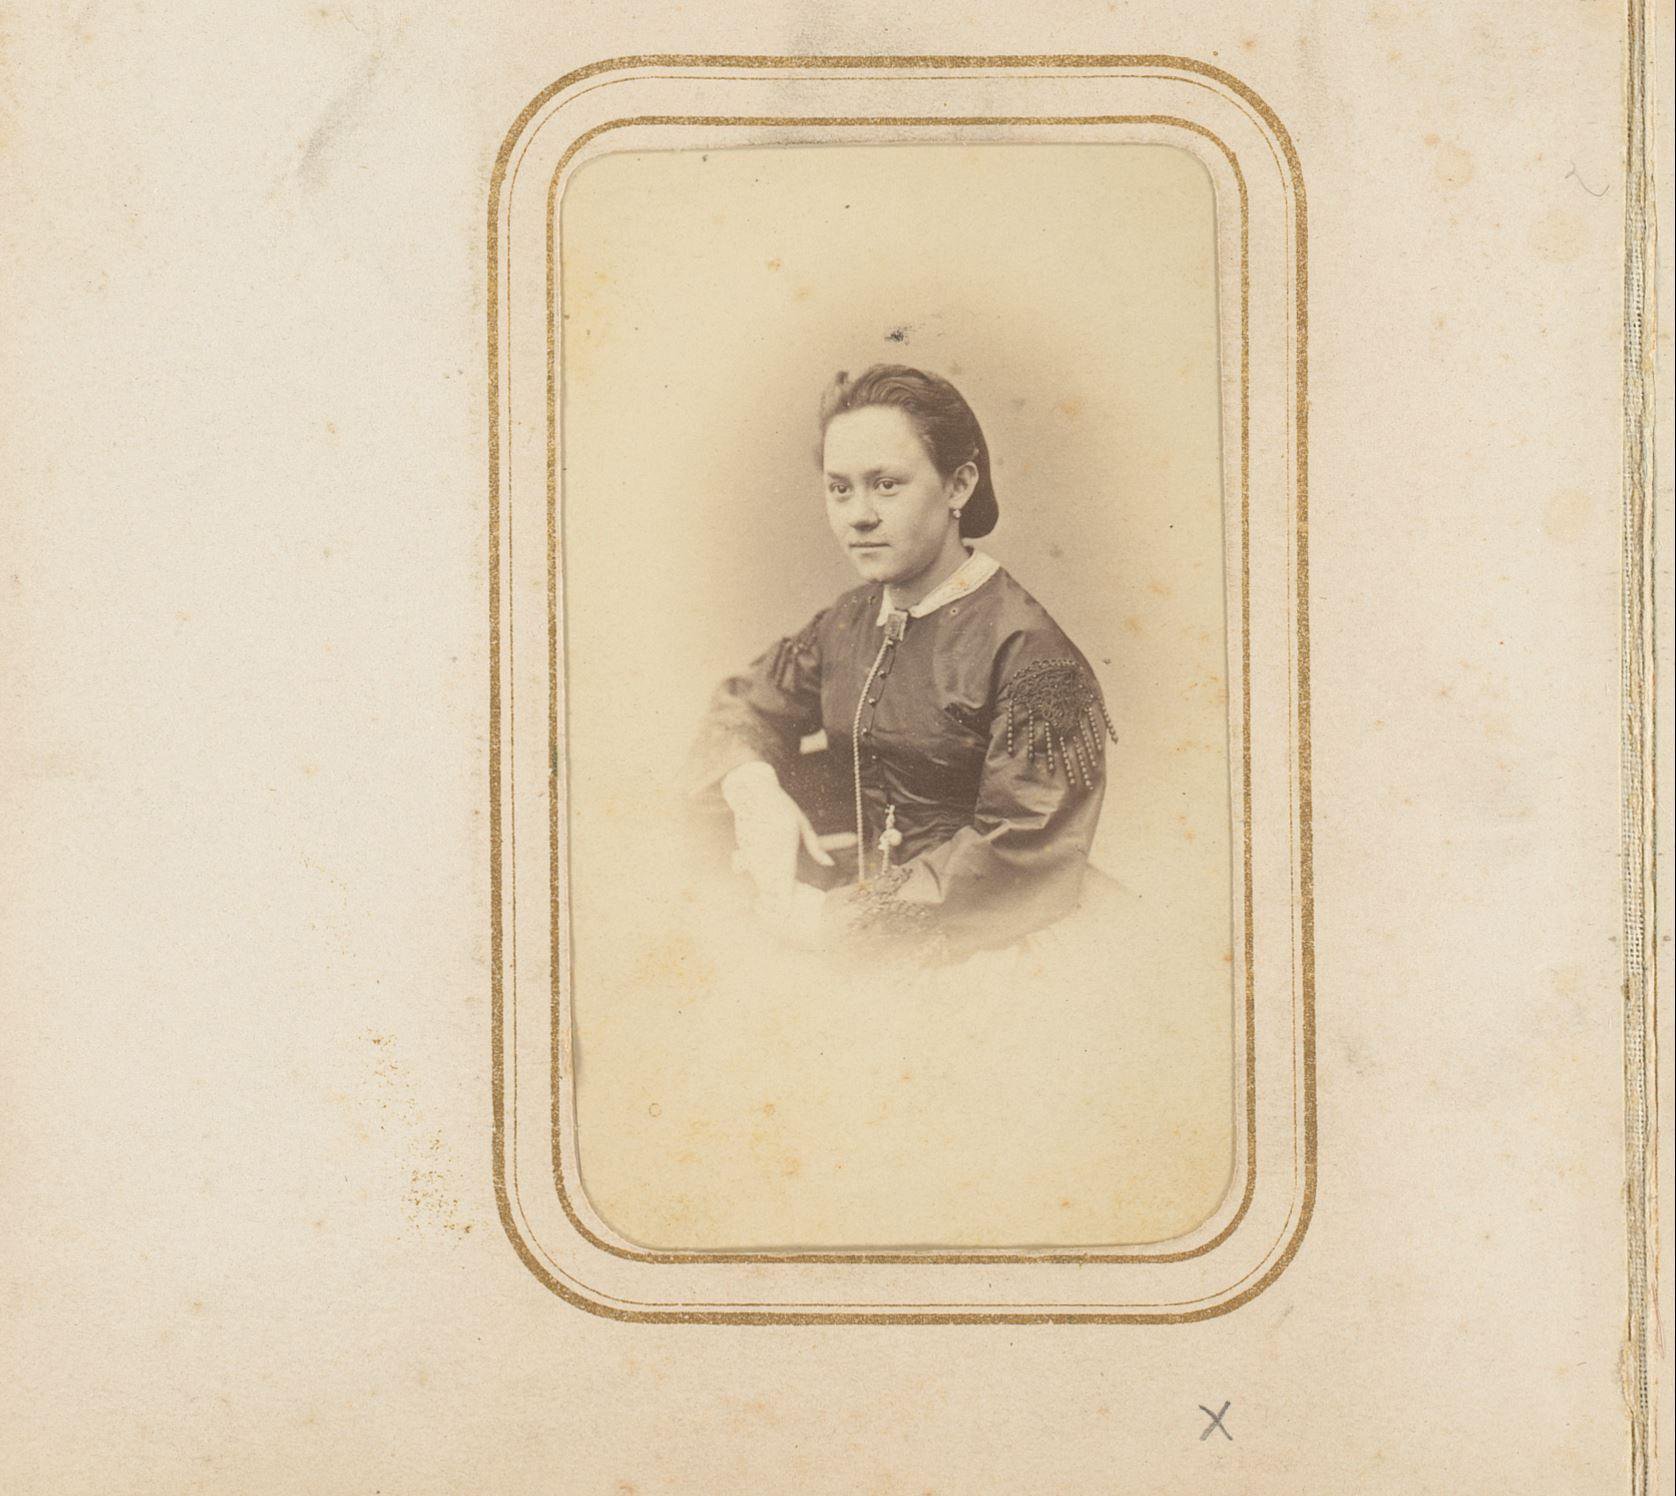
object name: photograph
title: Portret van een jonge vrouw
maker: albert greiner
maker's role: fotograaf, fotostudio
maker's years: 1833-1890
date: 1861-1874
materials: cardboard, photographic support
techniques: albumen print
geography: amsterdam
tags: adolescent, young woman, maiden, historical persons - bb - woman